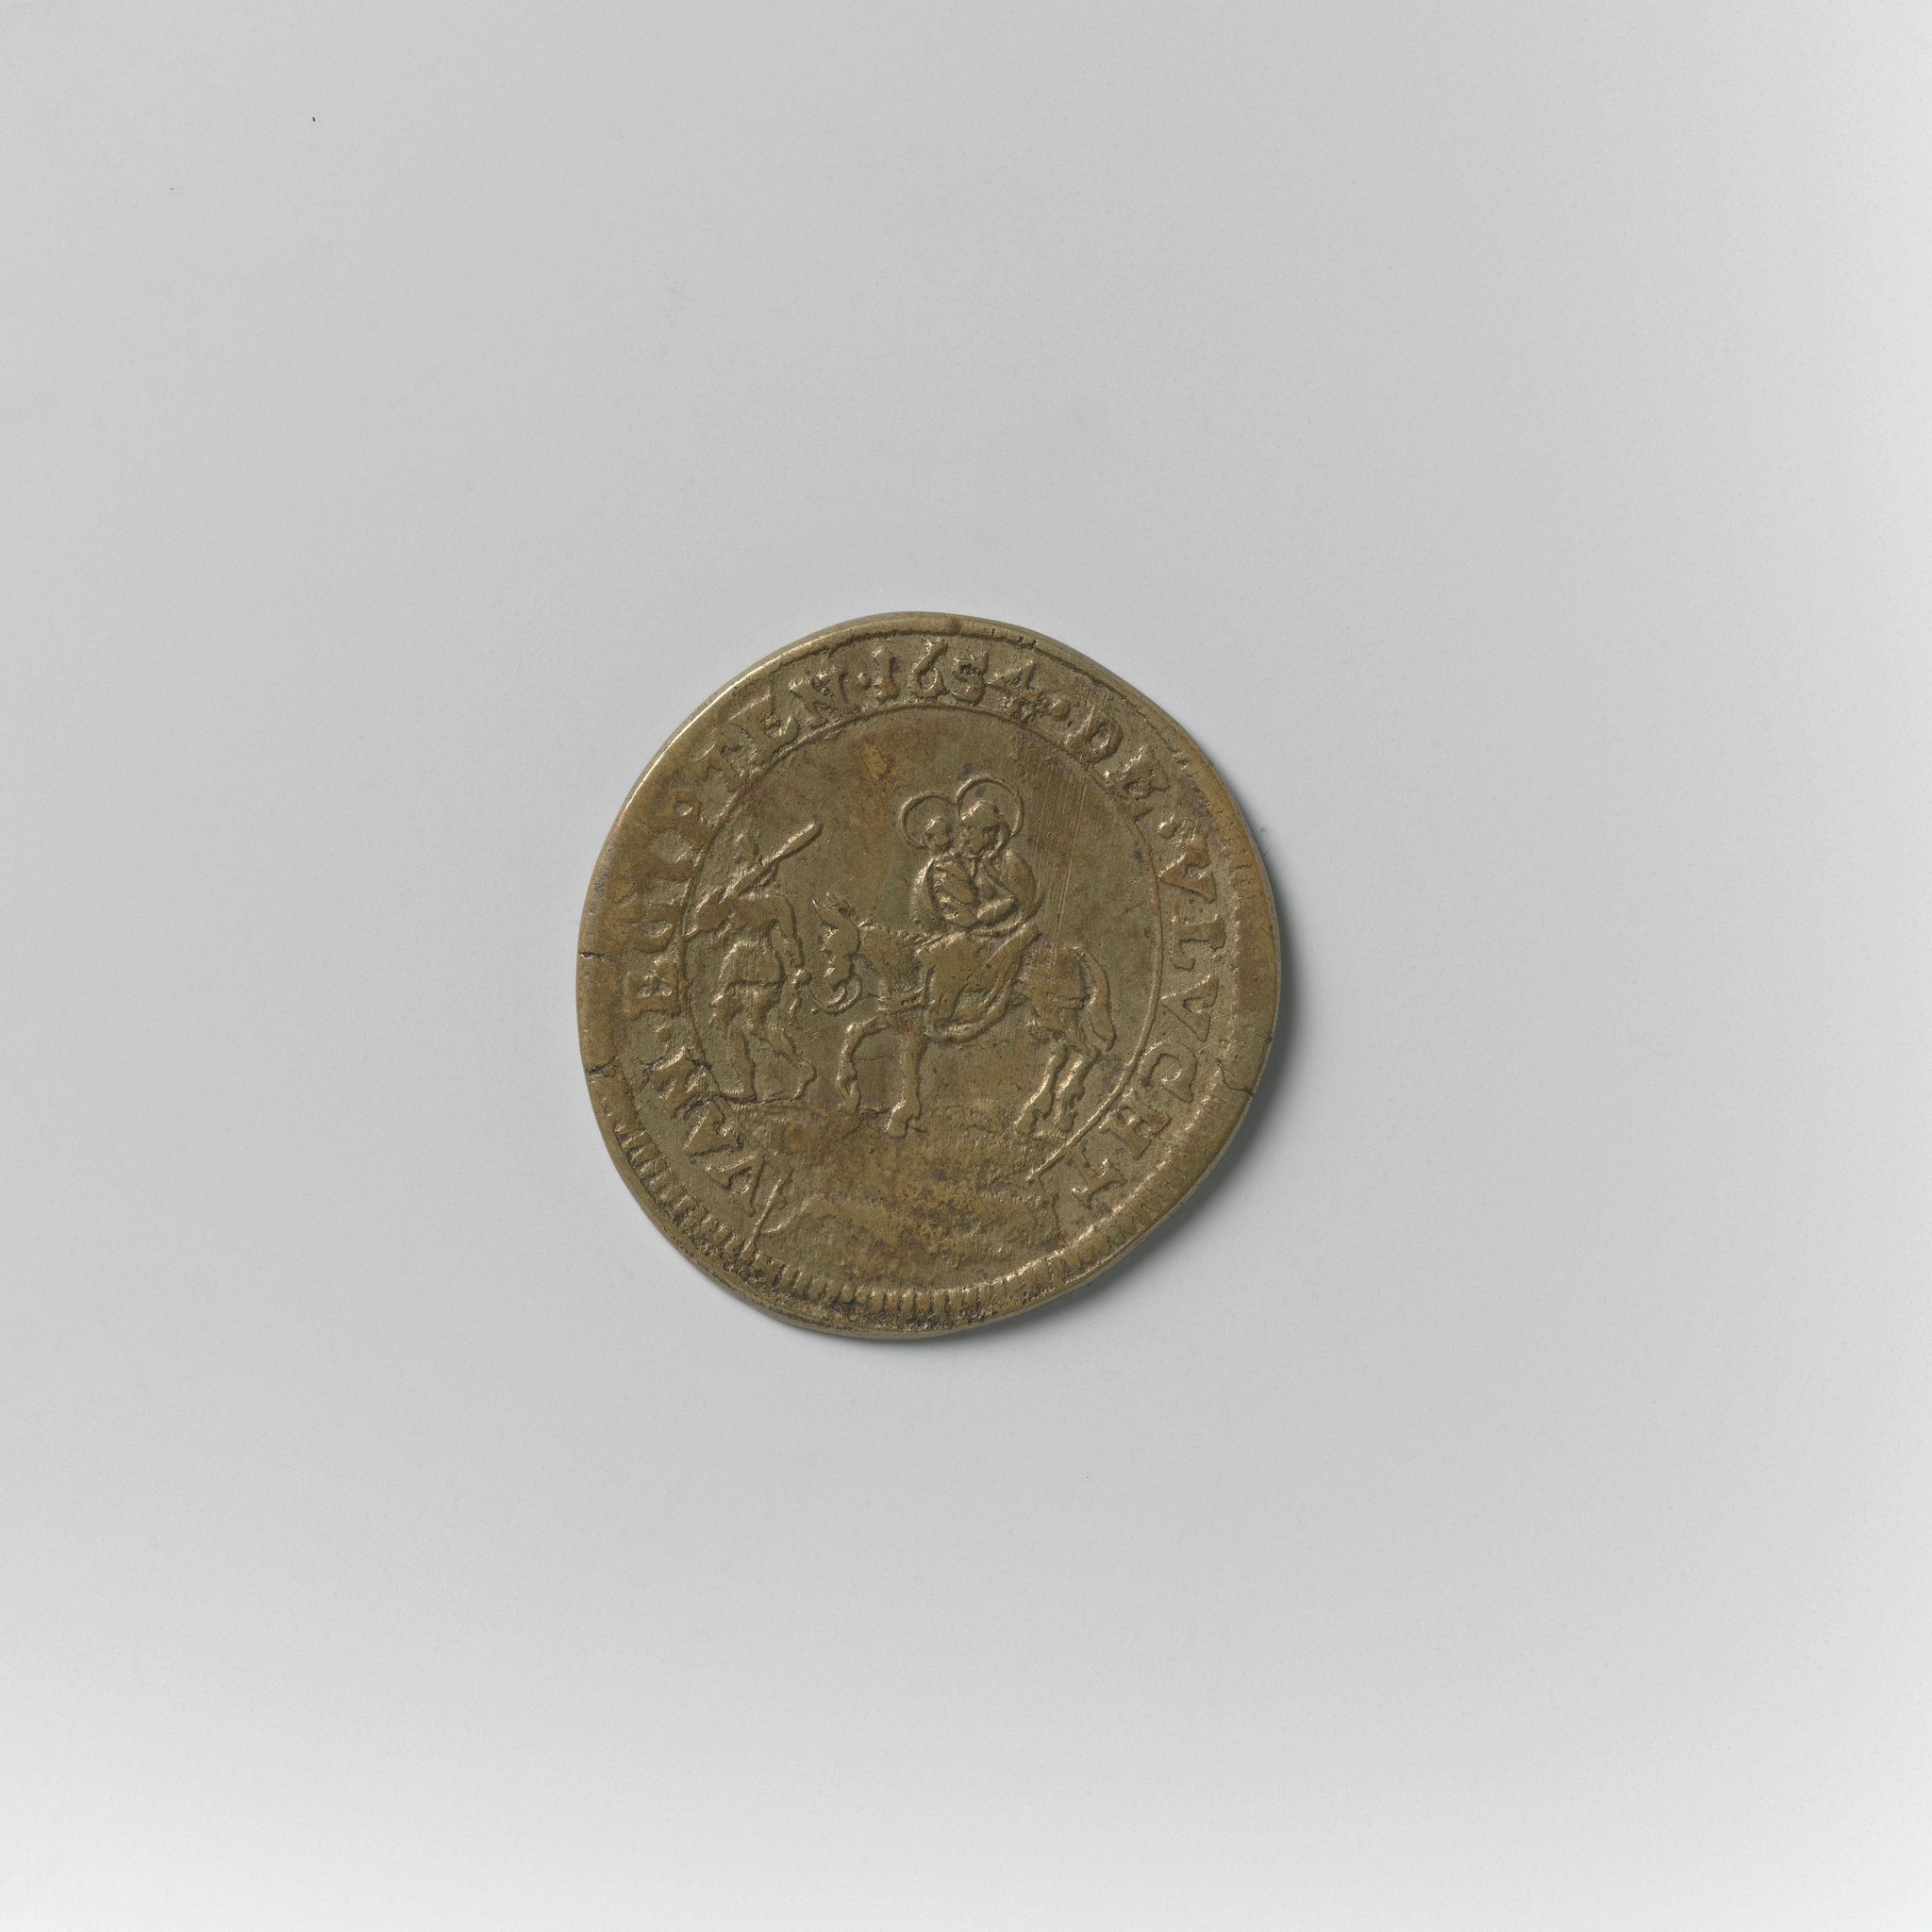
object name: medal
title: Presentiepenning van het Sint Joseph- of Timmermansgilde te Amsterdam, 1654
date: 1654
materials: brass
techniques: casting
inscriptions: circumscription: ‘DE.VLVCHT. - .VAN.EGIPTEN.1654.’, inscription: ‘ANTONI VAN / LUGTENBURG’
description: Gegoten messing penning met op de voorzijde Jozef met stok en Maria met Jezus op ezel naar links, met omschrift, op de gladde keerzijde twee regels tekst, op naam van Antoni van Lugtenburg